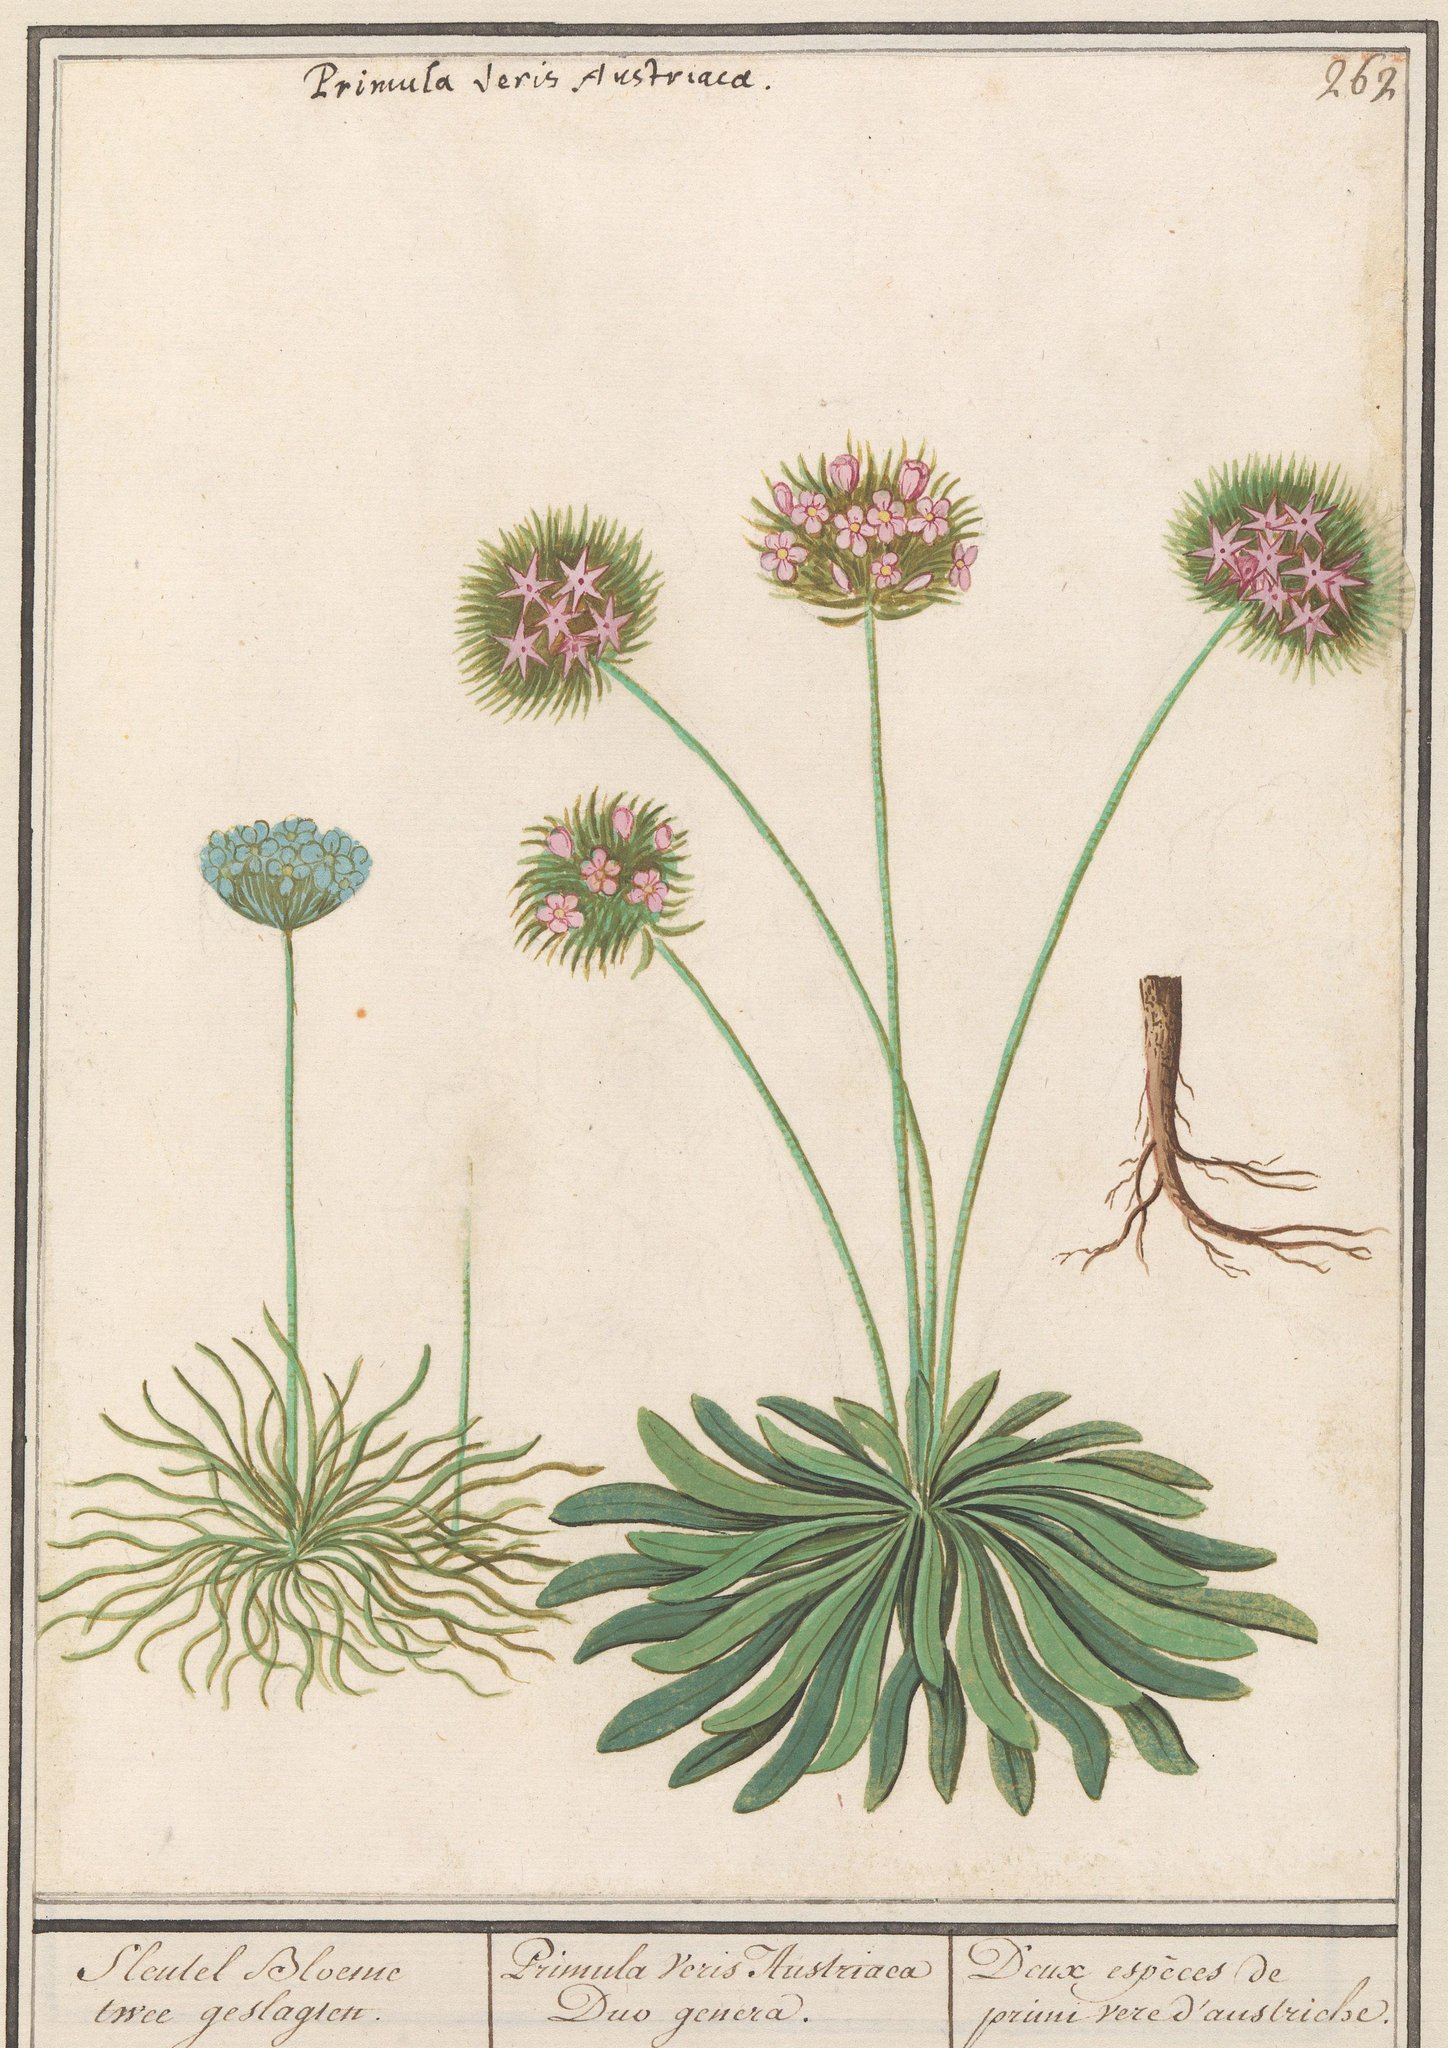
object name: drawing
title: Sleutelbloem (Primula)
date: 1596-1610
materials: chalk, paint, ink, paper, watercolor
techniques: brush, pen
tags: flowers: primula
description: Twee soorten sleutelbloem. Genummerd rechtsboven: 262. Bovenaan de Latijnse naam. Onderdeel van het derde album met tekeningen van bloemen en planten. Tiende van twaalf albums met tekeningen van dieren, vogels en planten bekend rond 1600, gemaakt in opdracht van keizer Rudolf II. Met toelichting in Nederlands, Latijn en Frans.